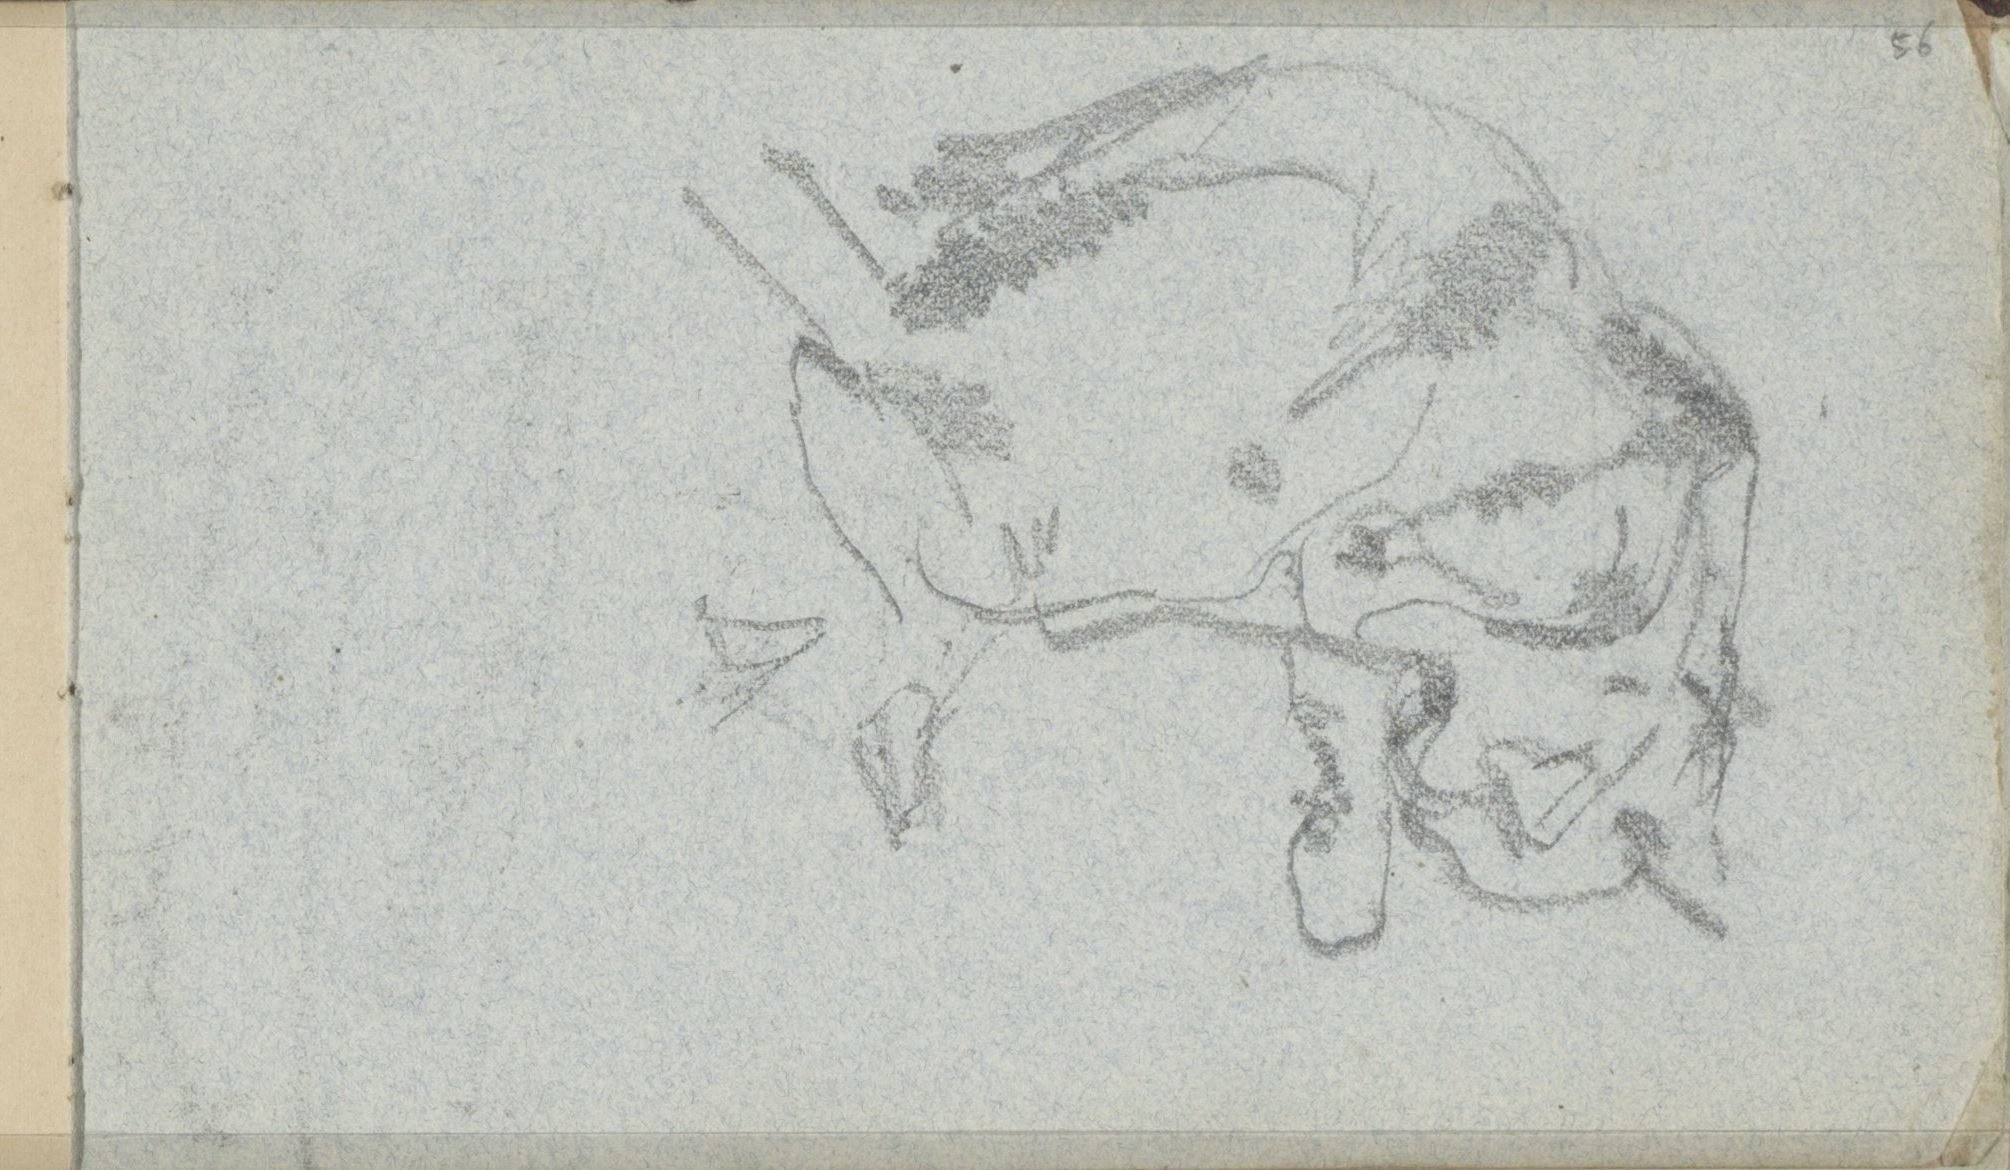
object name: sketchbook leaf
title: Kat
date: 1881-1883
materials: paper, pencil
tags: cat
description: Pagina 56 uit een schetsboek met 30 bladen.